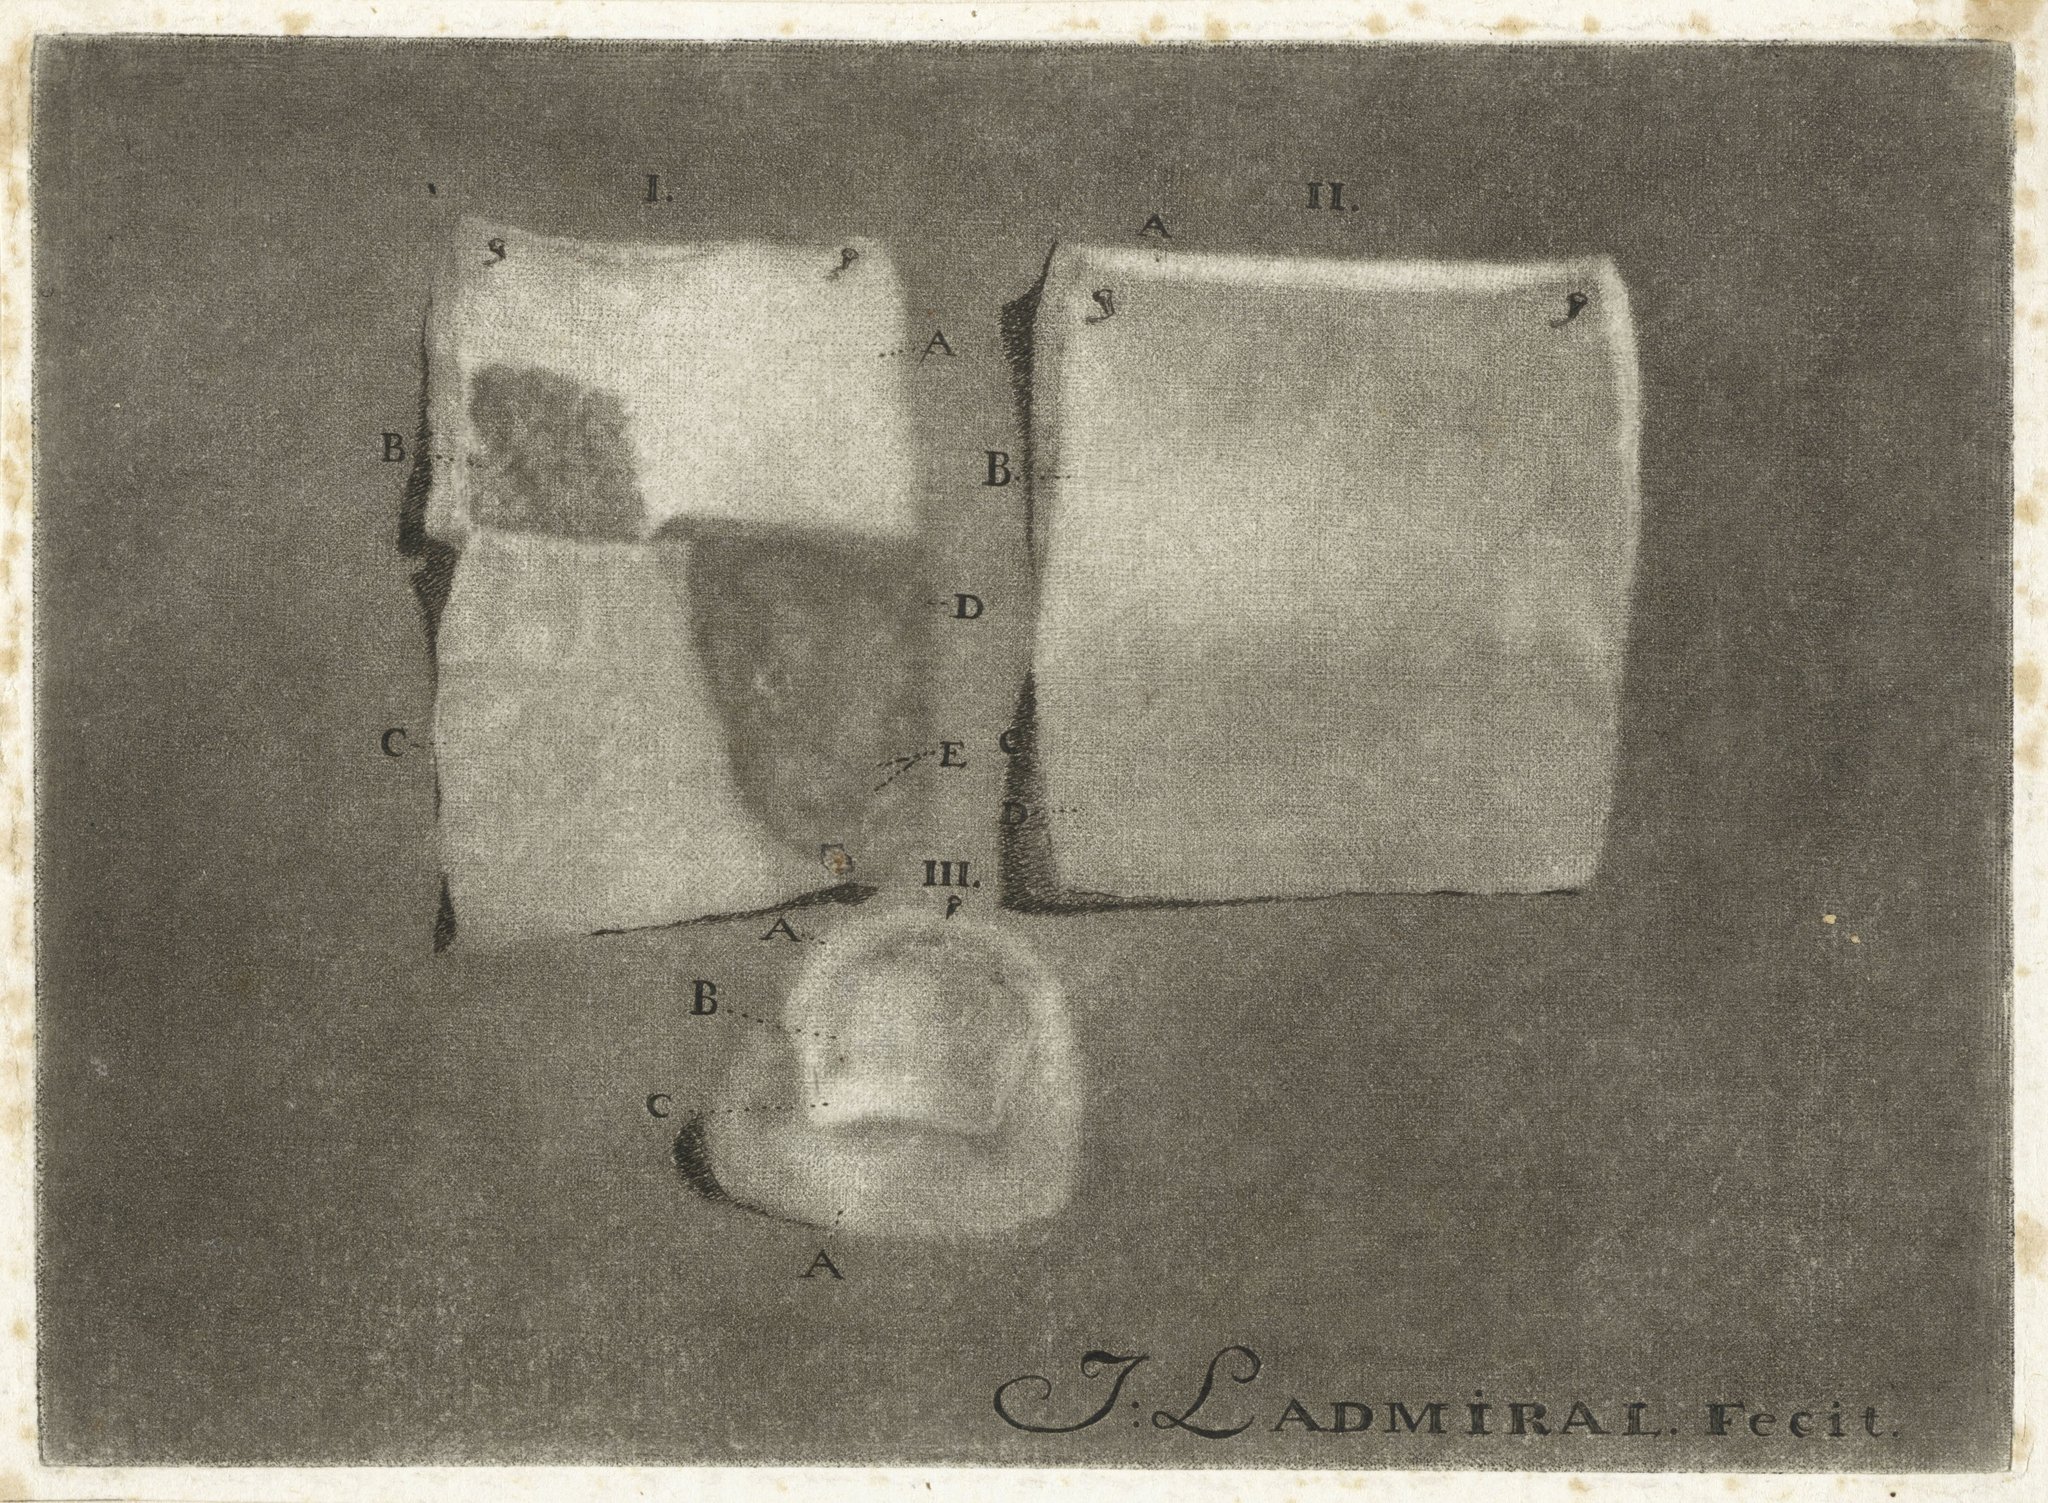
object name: print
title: Anatomische studie van menselijke huid en nagel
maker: jan l admiral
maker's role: draughtsman, print maker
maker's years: 1699-1773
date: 1737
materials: paper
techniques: etching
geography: amsterdam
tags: other anatomical details, skin (human), nails (fingers)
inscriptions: collector's mark: Lugt 2228, collector's mark: Lugt 2233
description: Jan L'Admiral gebruikte voor de groep mezzotinten met het onderwerp 'Anatomische studie van menselijke huid en nagel' vier verschillende platen: A, B, C en D. Proefdruk voor illustratie in: Albinus, Bernhard Siegfried. Dissertatio secunda. De sede et caussa coloris Aethiopum et caeterorum hominum, Leiden: Dirk Haak (II) en Amsterdam: Jacob Graal en Hendrik de Leth, 1737.